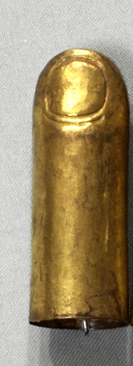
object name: finger stall, group 2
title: Finger stall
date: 1479-1425 BCE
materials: gold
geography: egypt